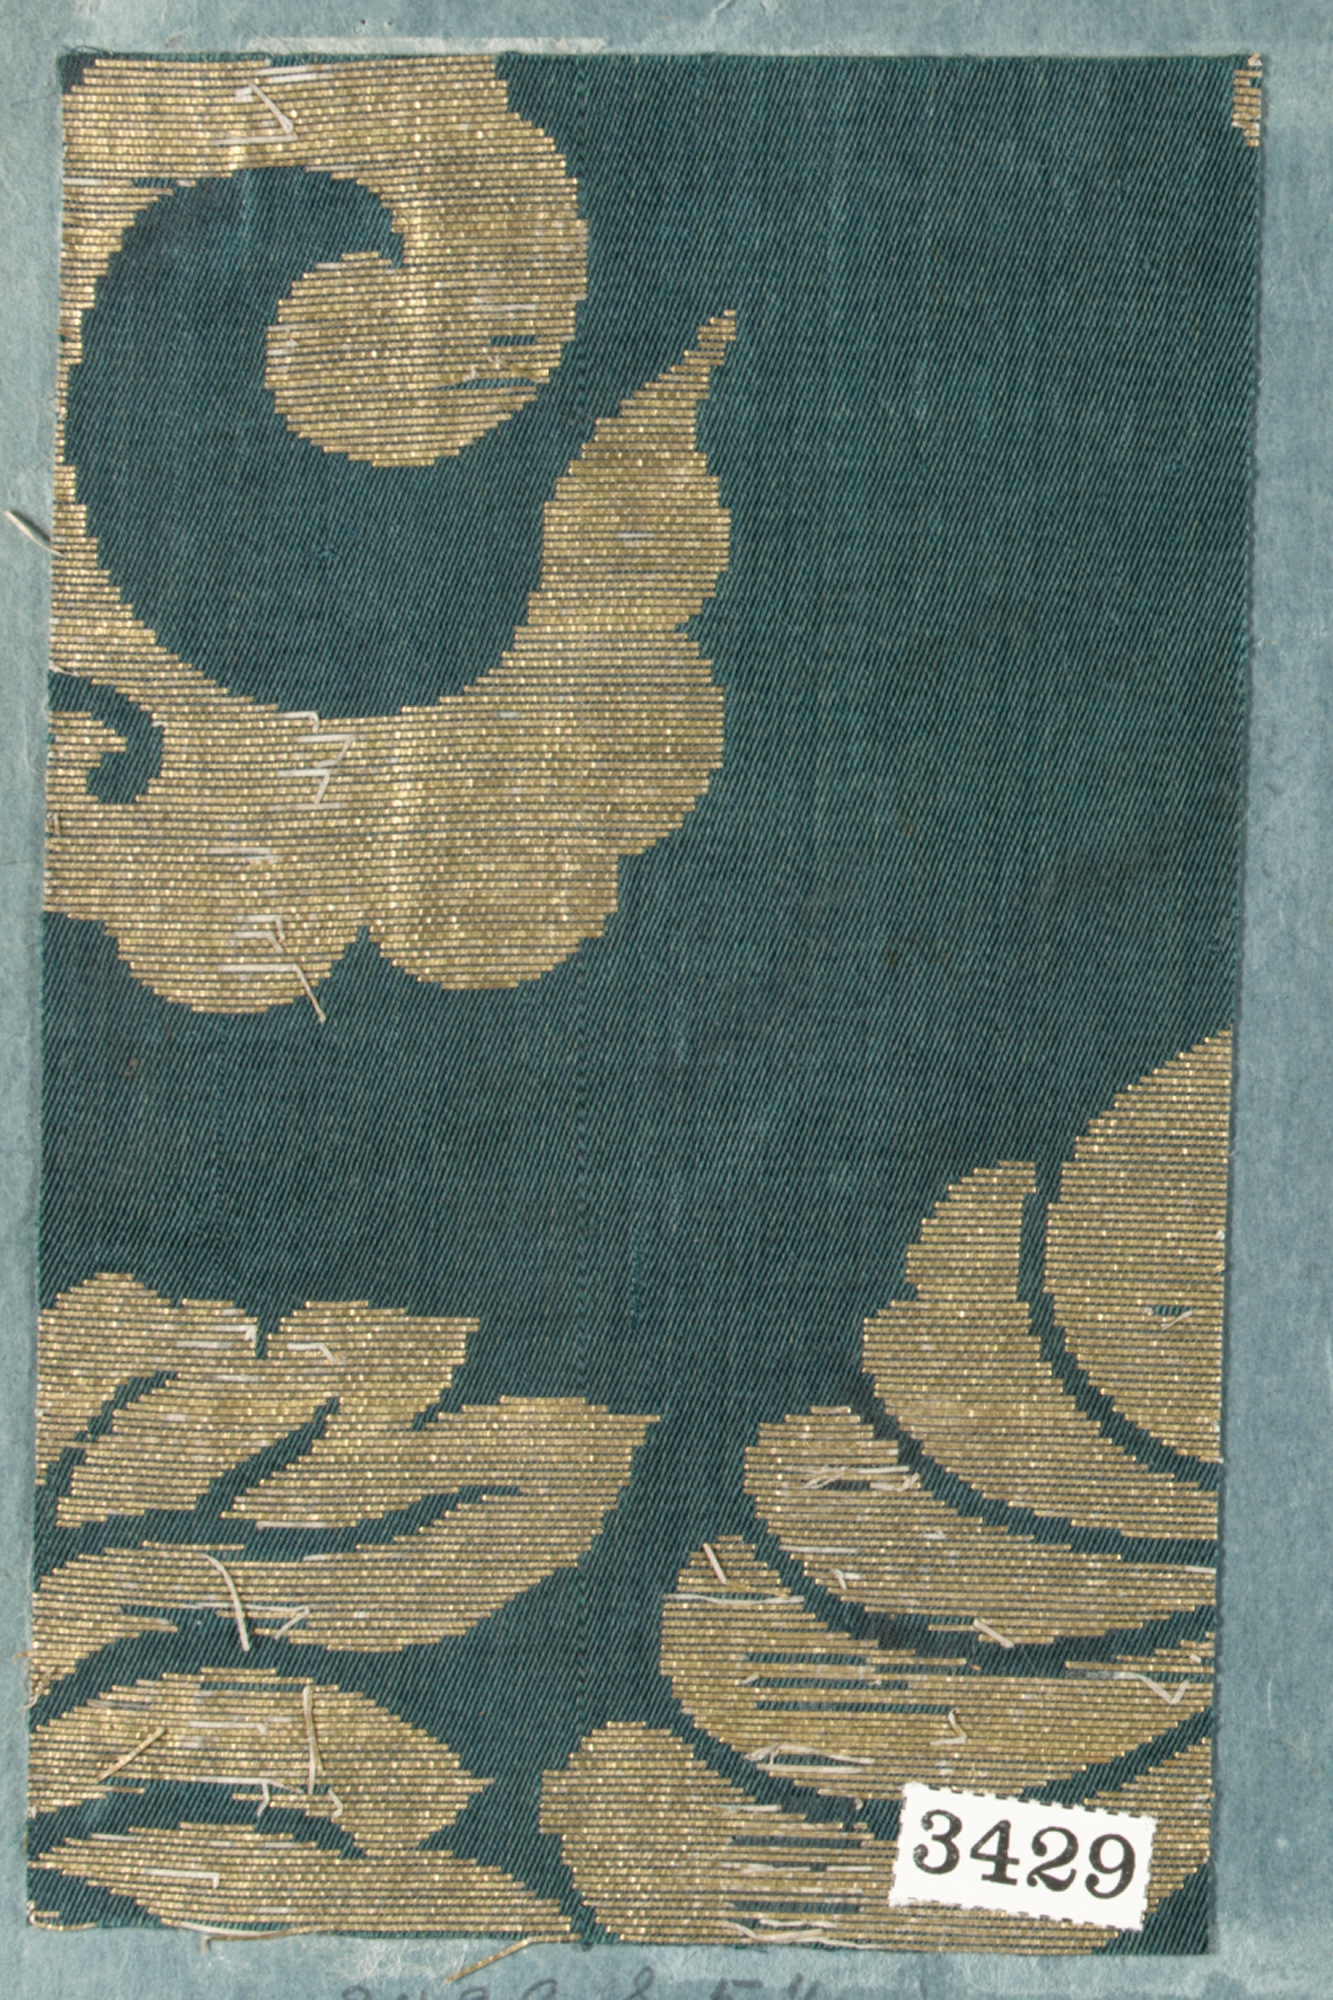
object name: textile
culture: japanese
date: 1801-1900